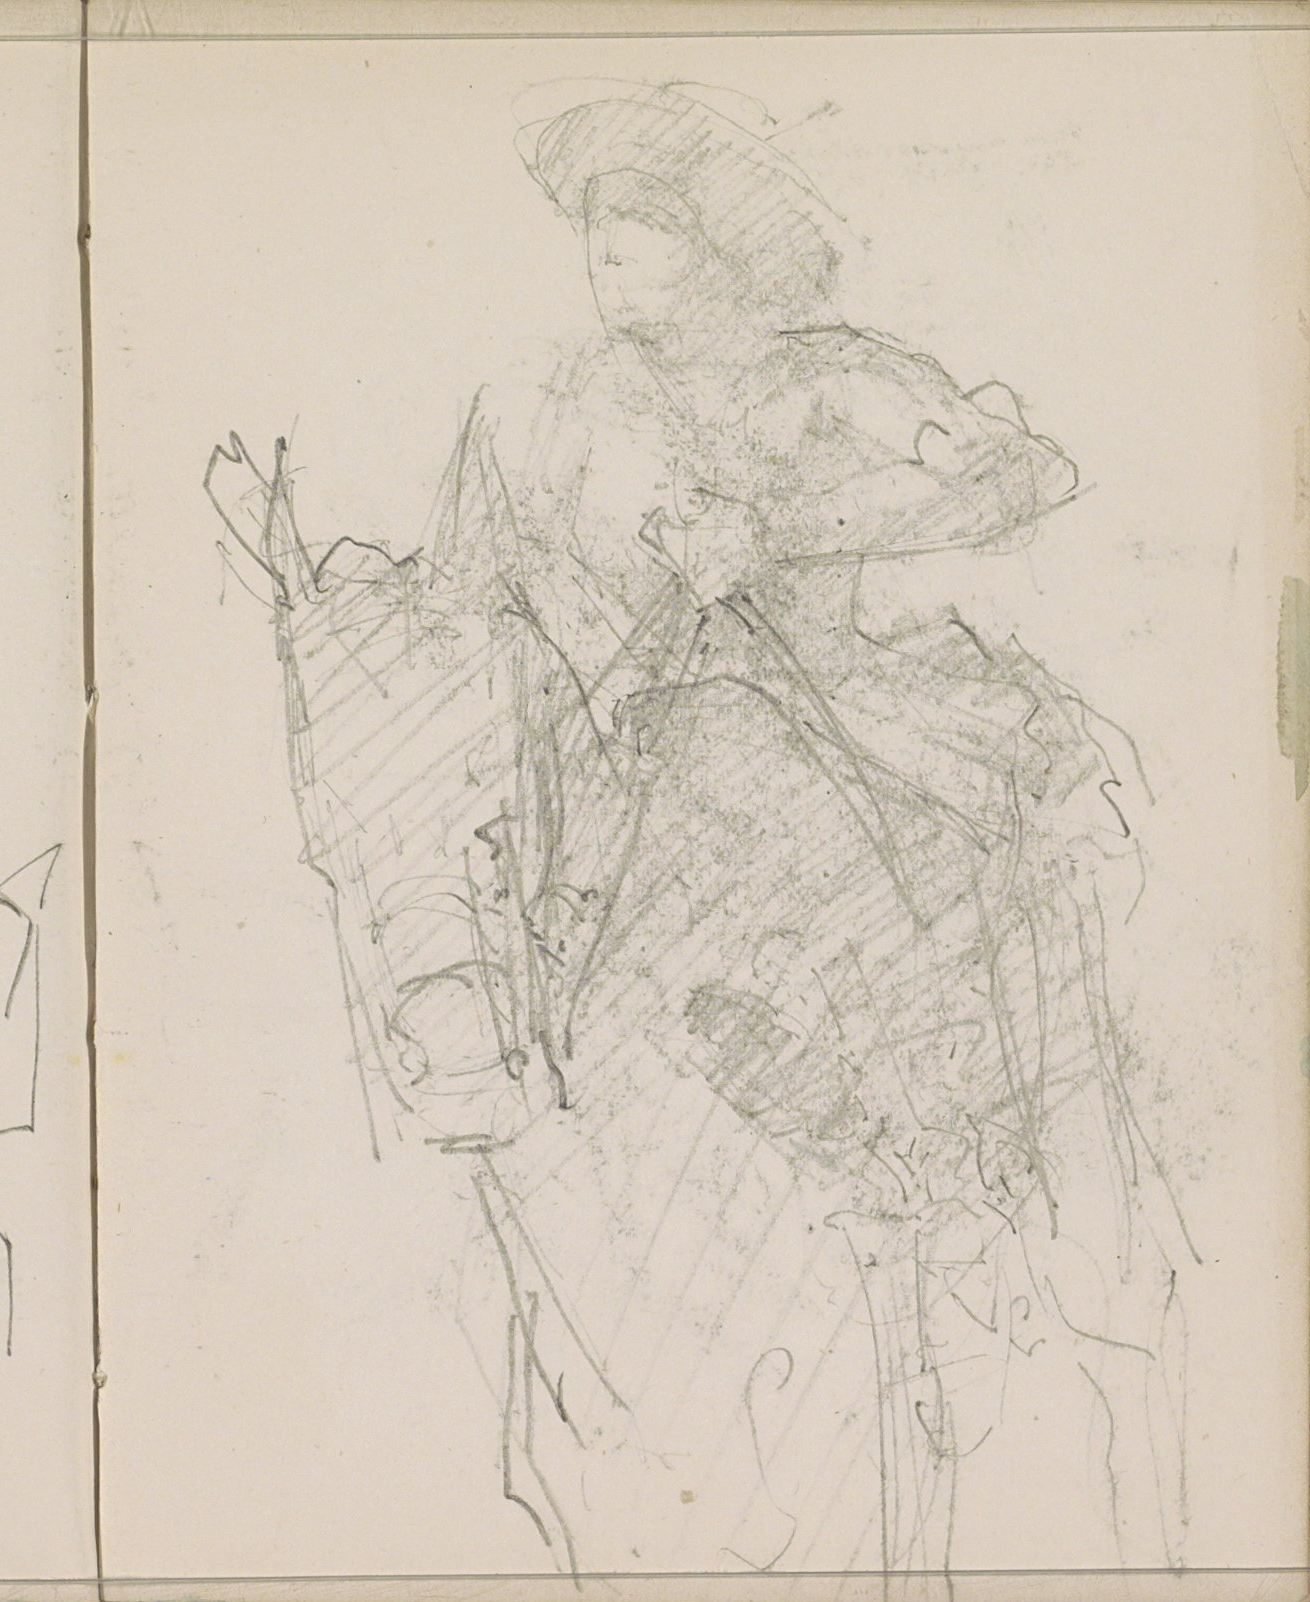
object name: sketchbook leaf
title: Ruiter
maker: reijer stolk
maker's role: draughtsman, print maker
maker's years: 1896-1945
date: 1916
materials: paper, pencil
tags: riding a horse, ass, or mule; rider, horseman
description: De man draagt een hoed met brede rand en houdt de teugels in zijn linkerhand. Blad 49 recto uit een schetsboek met 72 bladen.